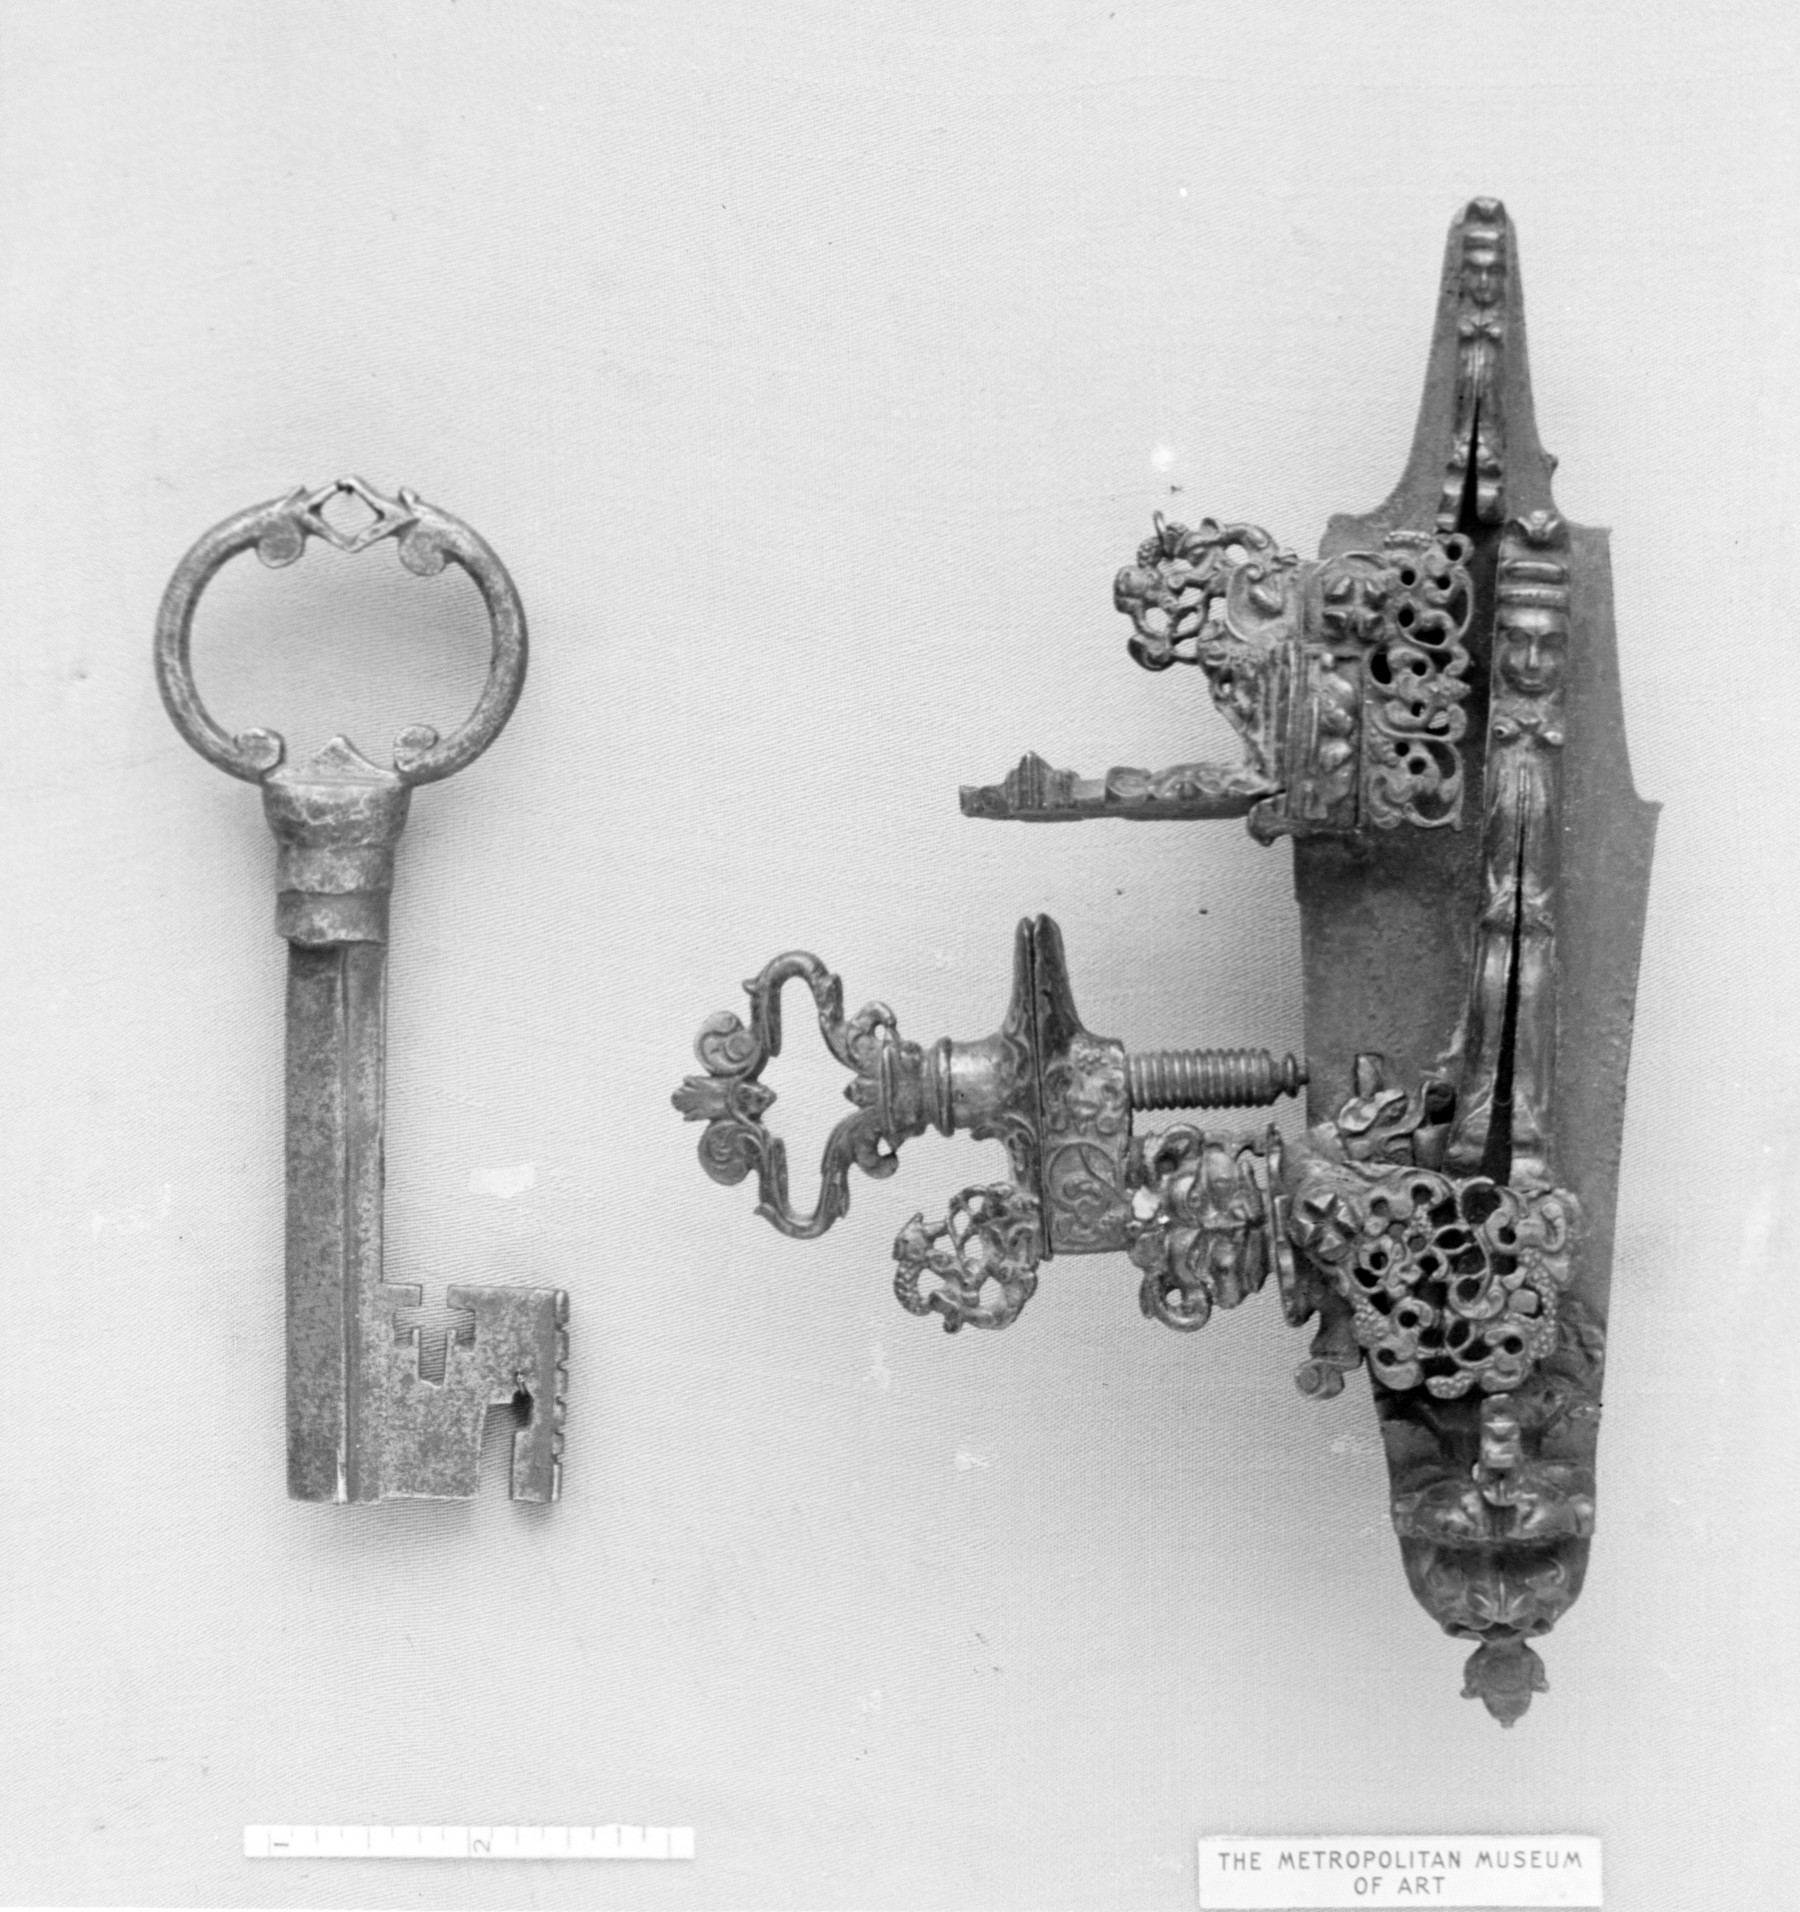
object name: key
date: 1501-1600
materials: iron